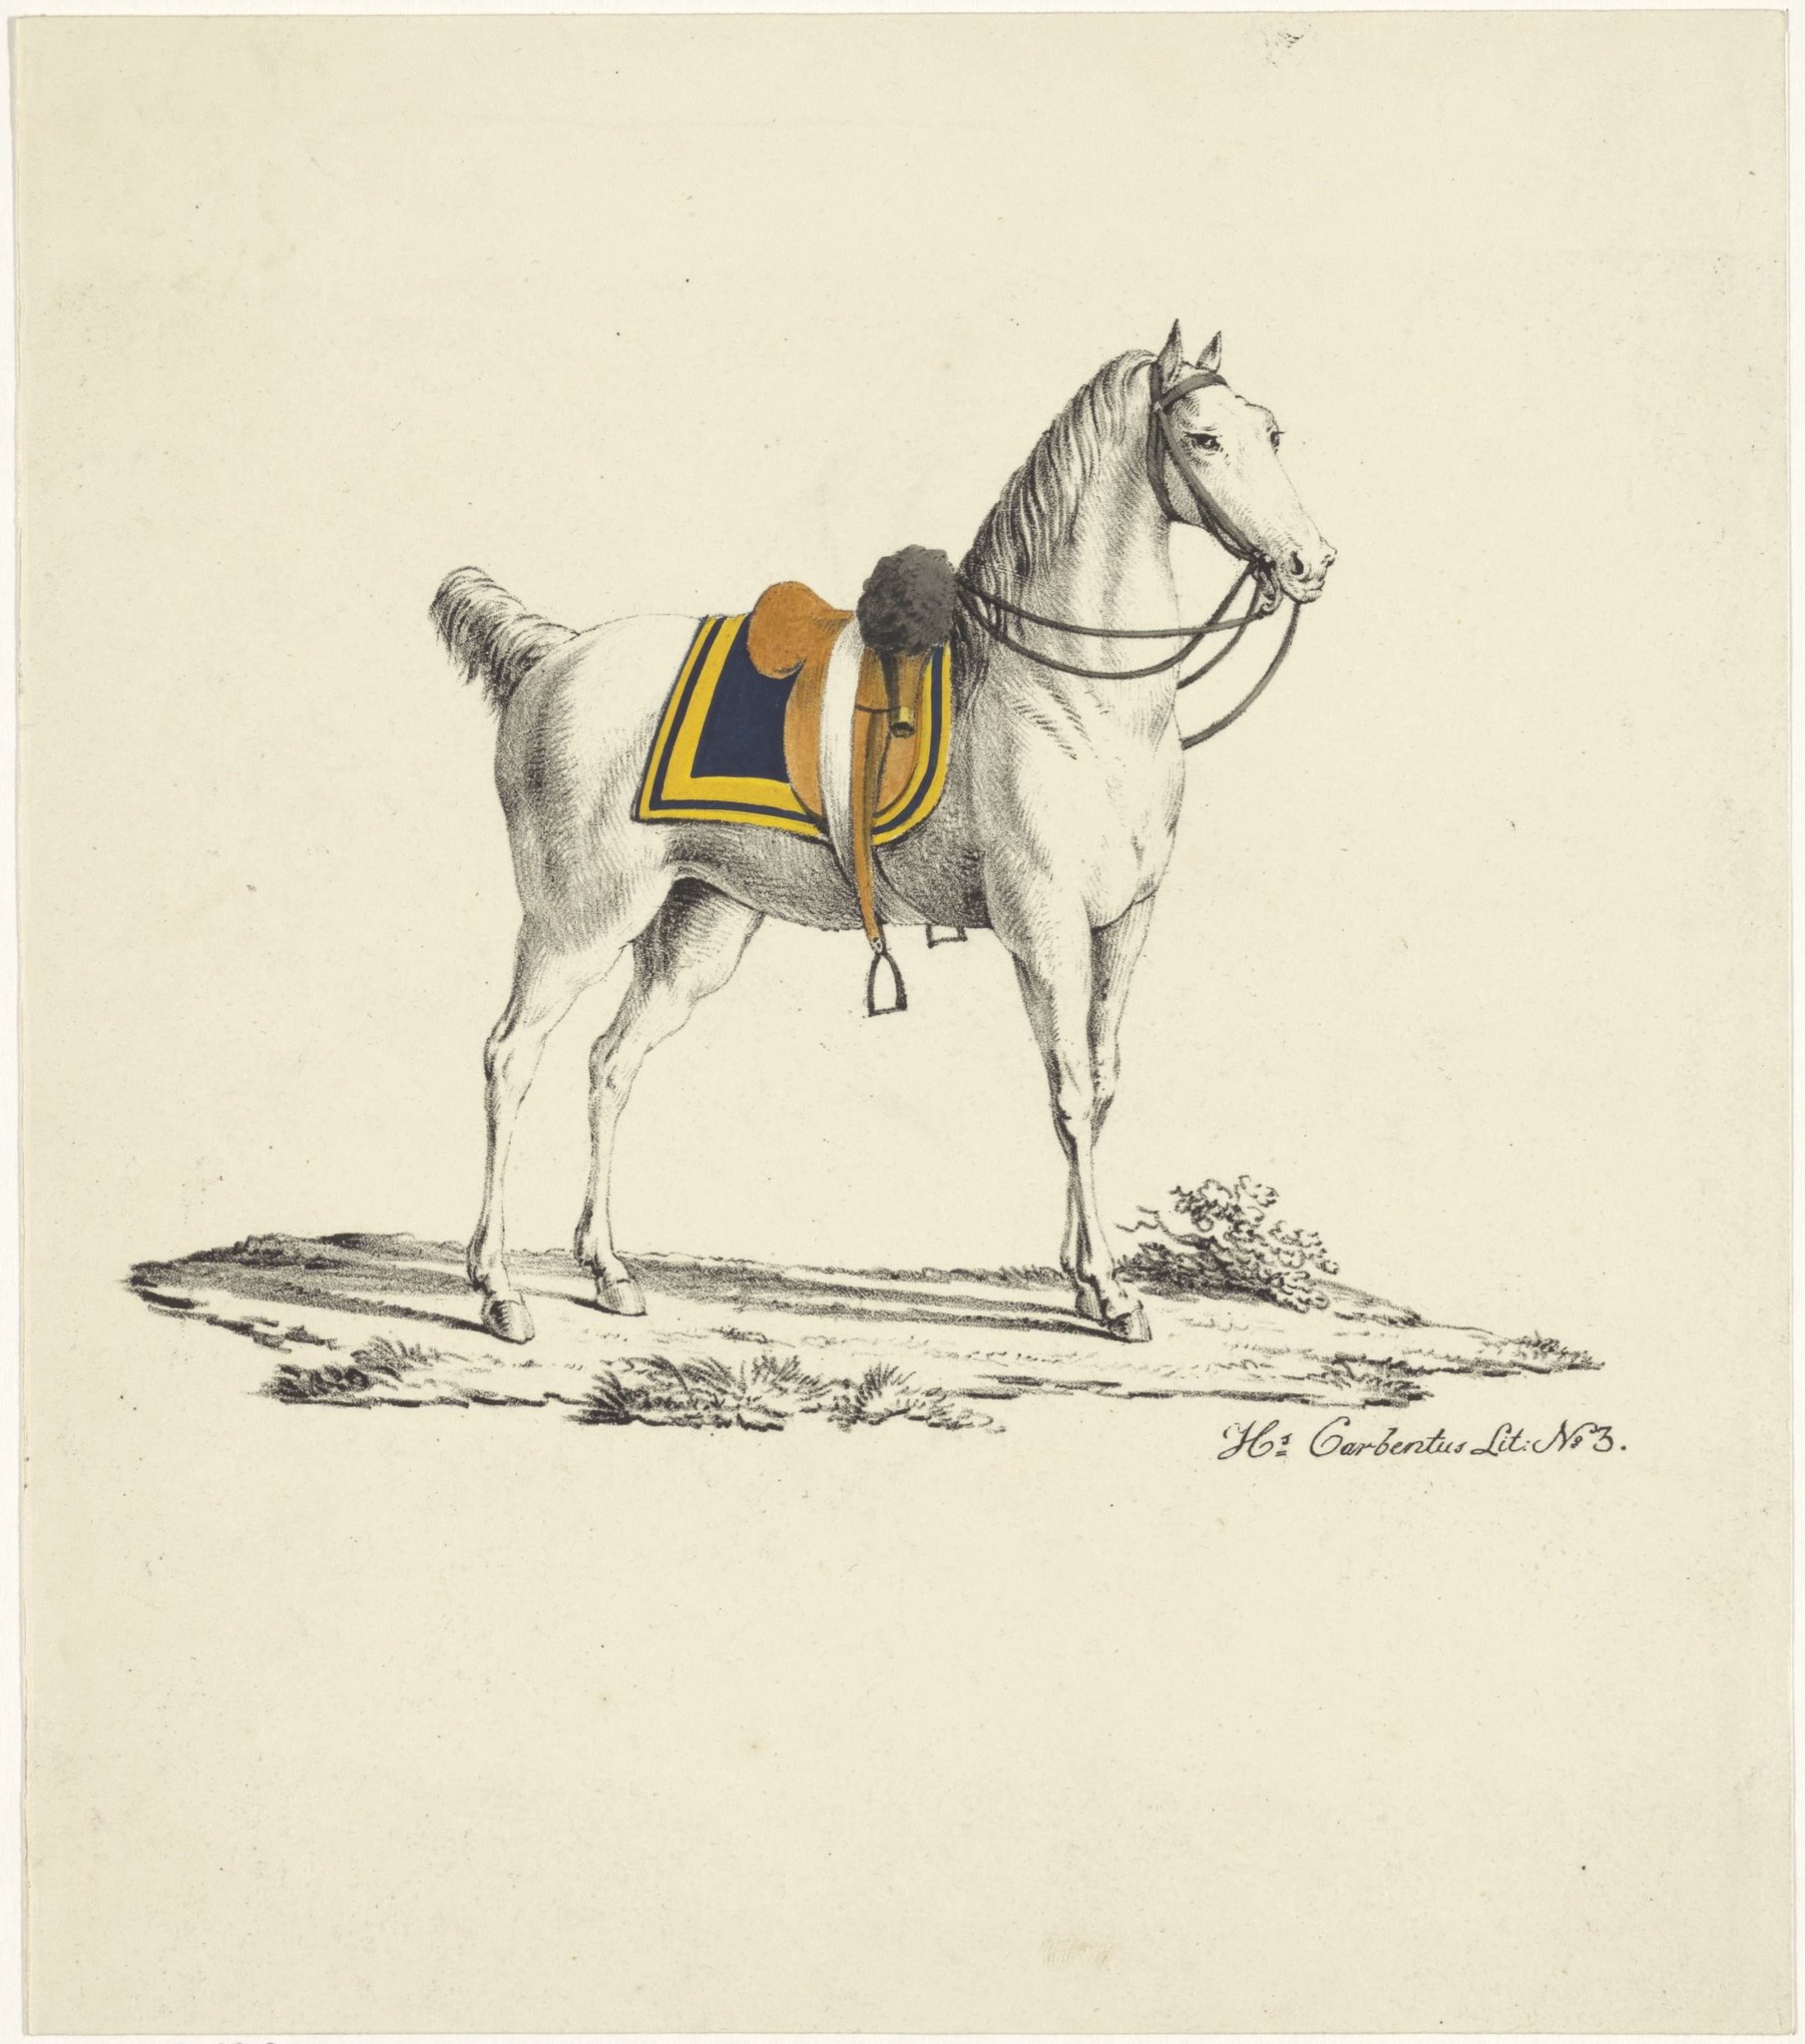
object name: print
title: Paard met zadel en hoofdstel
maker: hermanus carbentus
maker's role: print maker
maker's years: 1788-1854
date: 1809-1854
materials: paper, watercolor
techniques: hand coloring, lithograph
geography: the hague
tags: horse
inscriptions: collector's mark: Lugt 2228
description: Het paard draagt een hoofdstel zonder neusriem en dubbele teugels. Het dek van het zadel heeft een dubbele rand. Naast de signatuur van de prentmaker staat: No. 3.